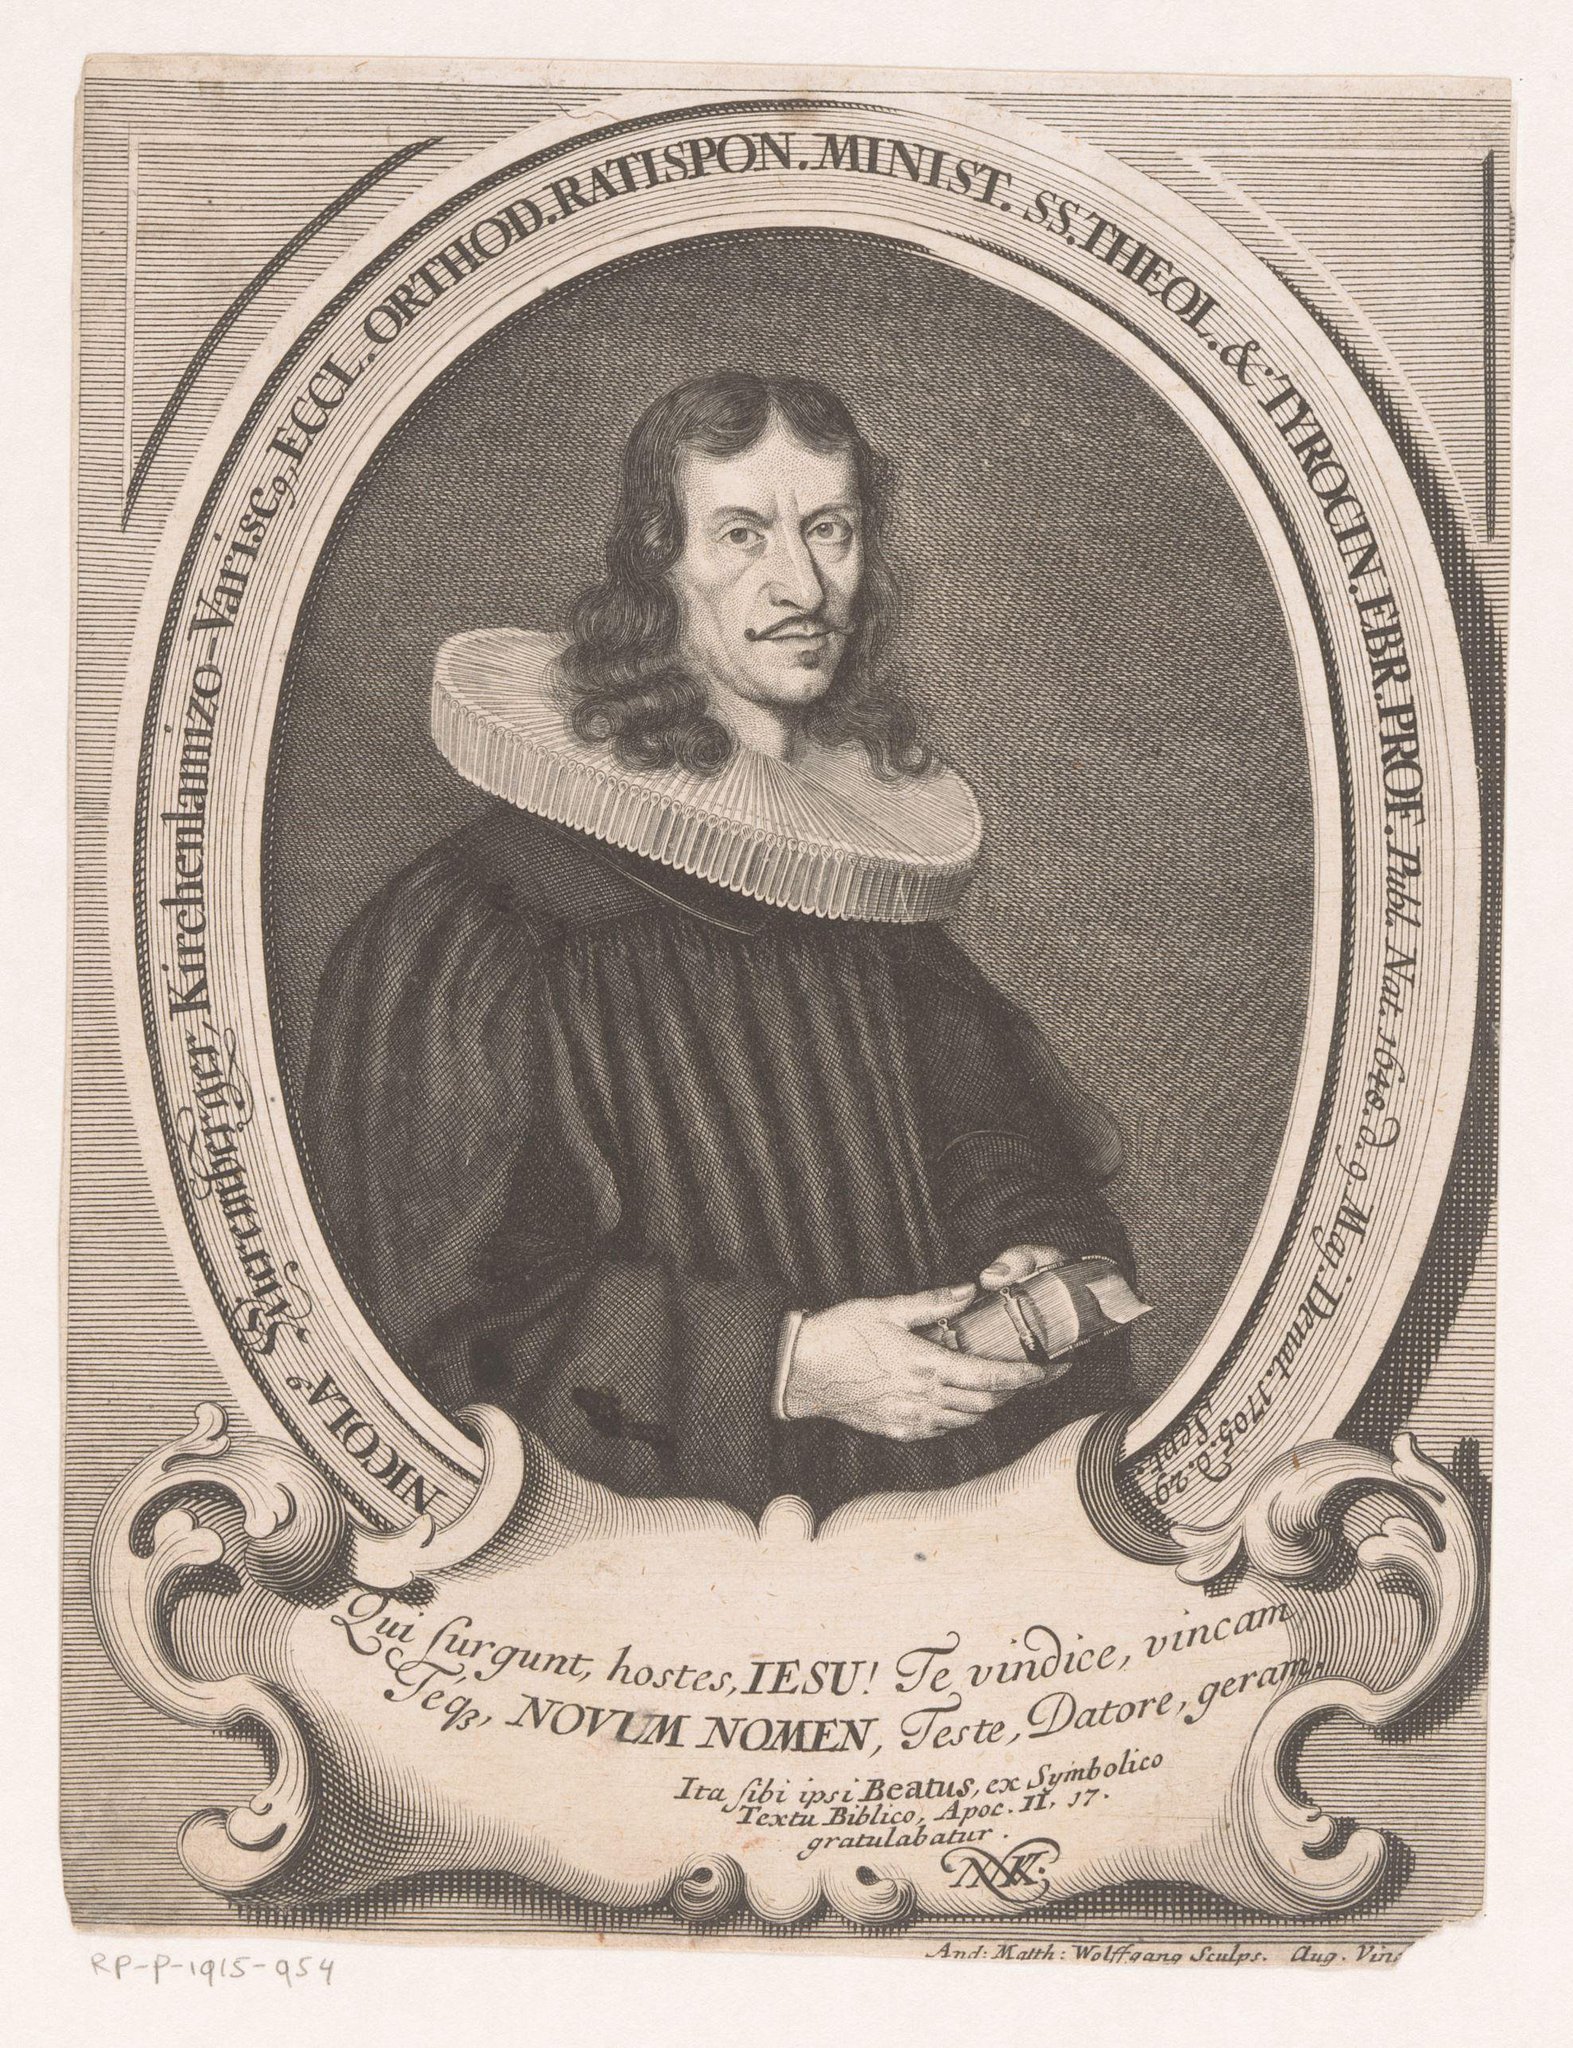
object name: print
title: Portret van Nicolaus Nieremberger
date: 1670-1737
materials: paper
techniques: engraving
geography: augsburg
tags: historical persons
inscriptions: collector's mark: Lugt 2228